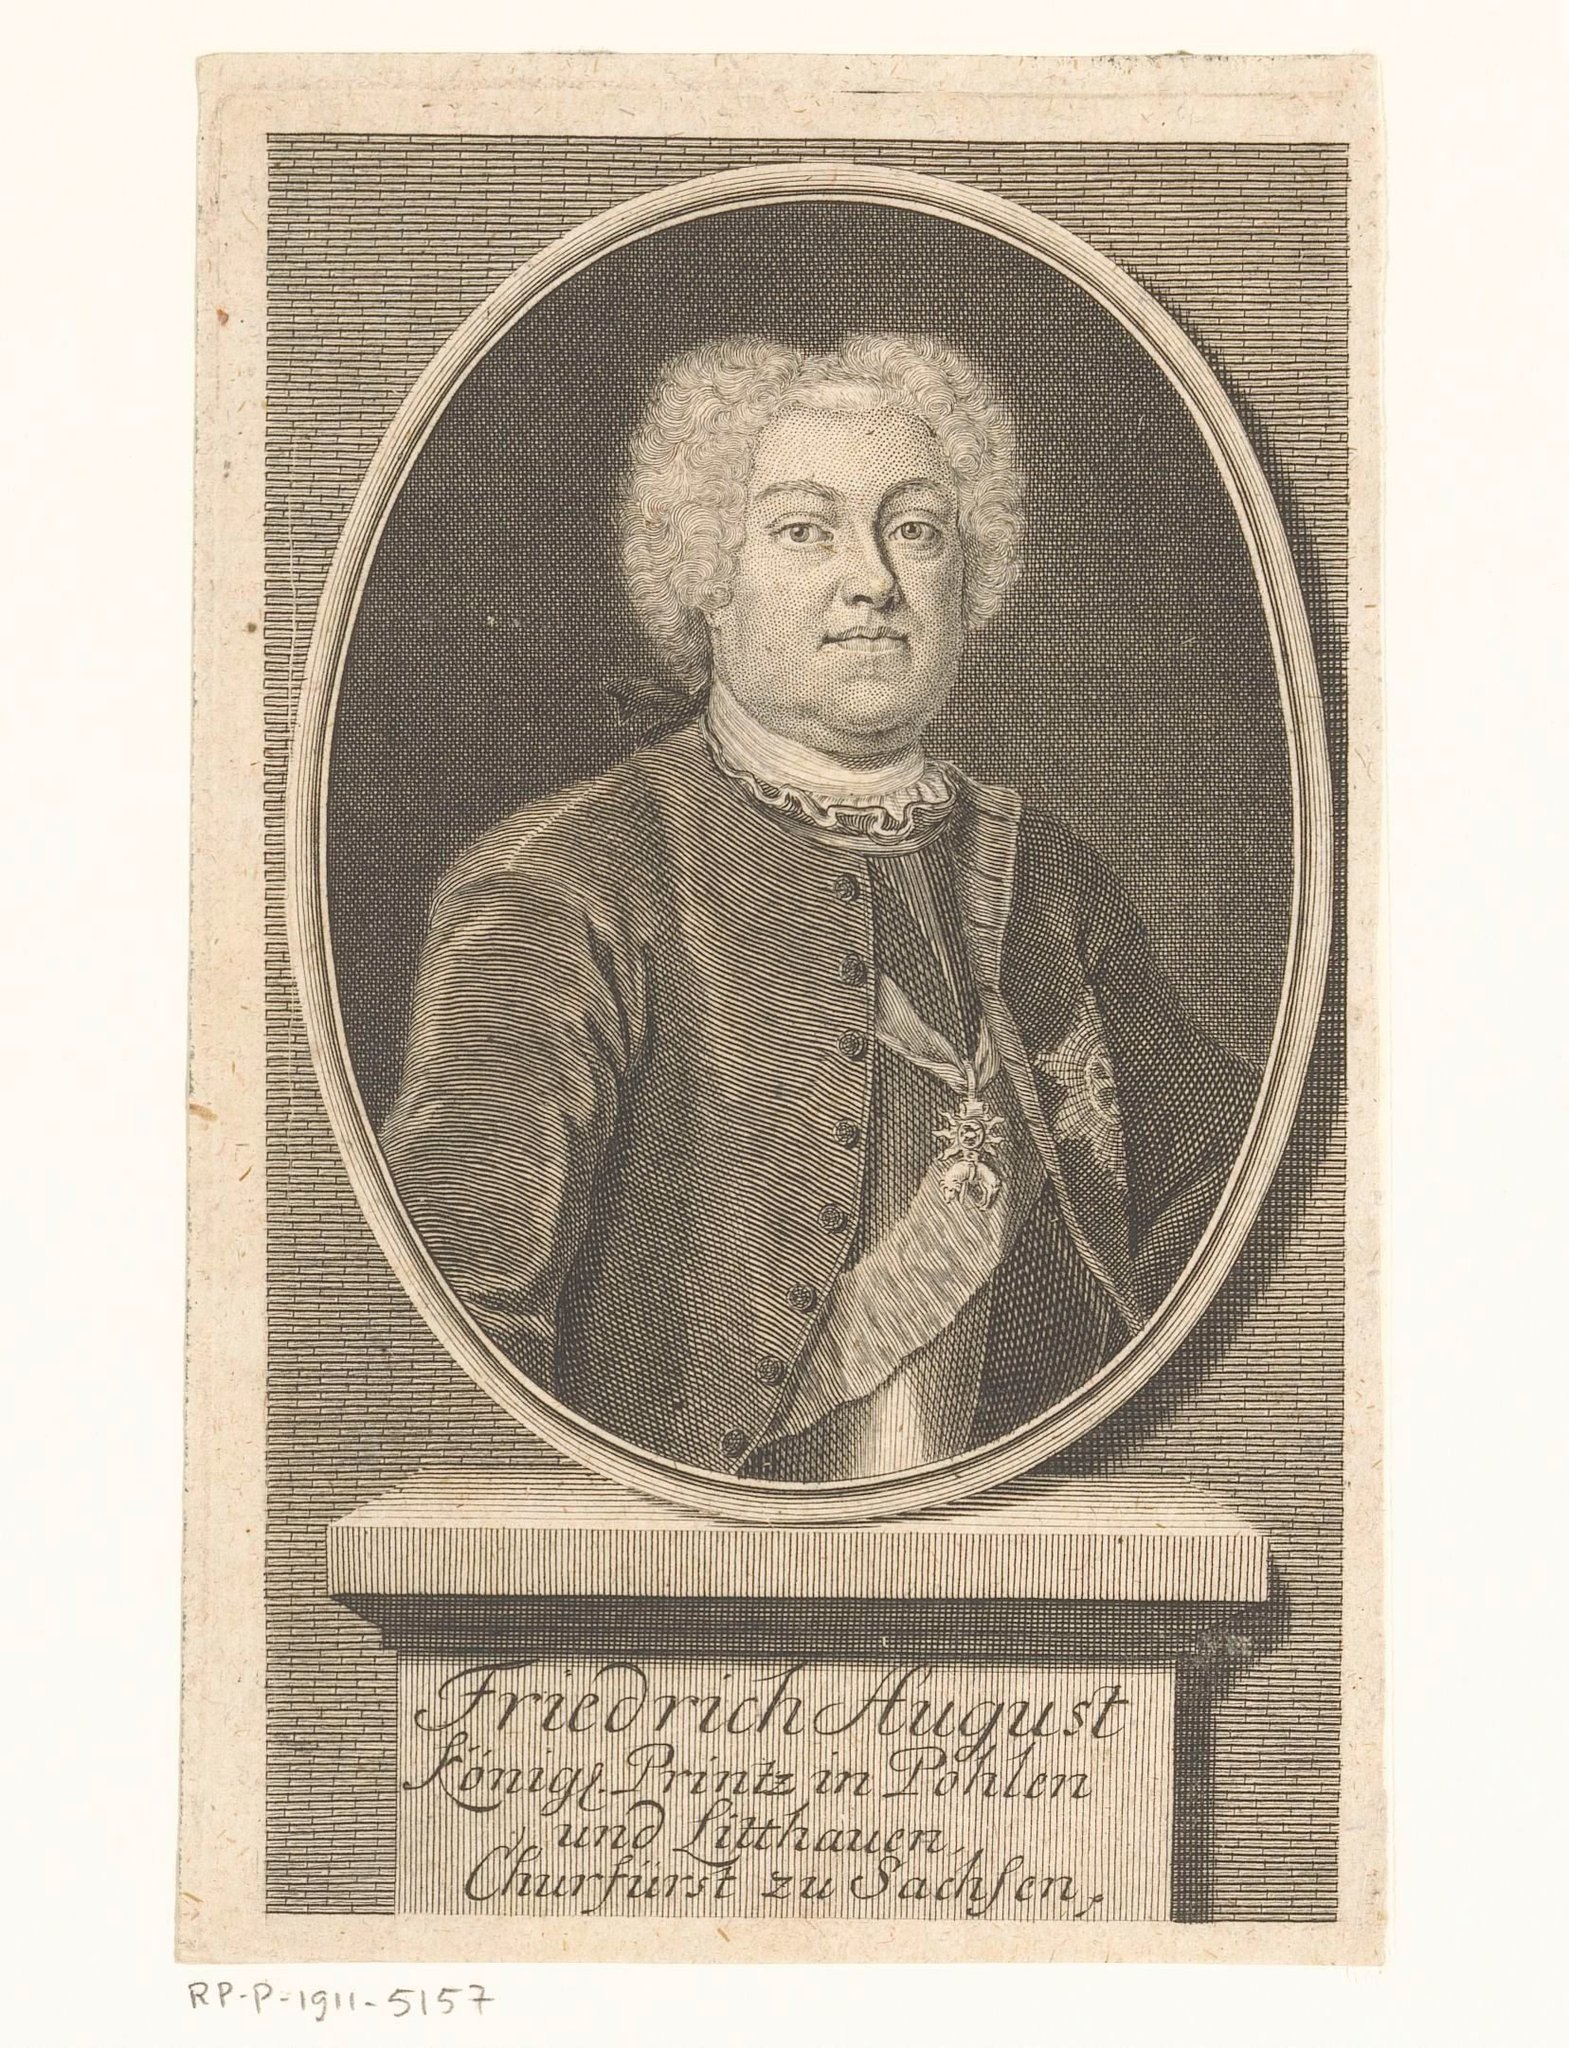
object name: print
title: Portret van August III van Polen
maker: martin bernigeroth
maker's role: print maker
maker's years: 1670-1733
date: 1722-1733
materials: paper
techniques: engraving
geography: leipzig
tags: augustus iii (king of poland), knighthood order (with name) - insignia of a knighthood order, e.g.: badge, chain (with name of order), historical persons, knighthood order of the golden fleece - insignia of a knighthood order, e.g.: badge, chain (with name of order)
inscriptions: collector's mark: Lugt 2228